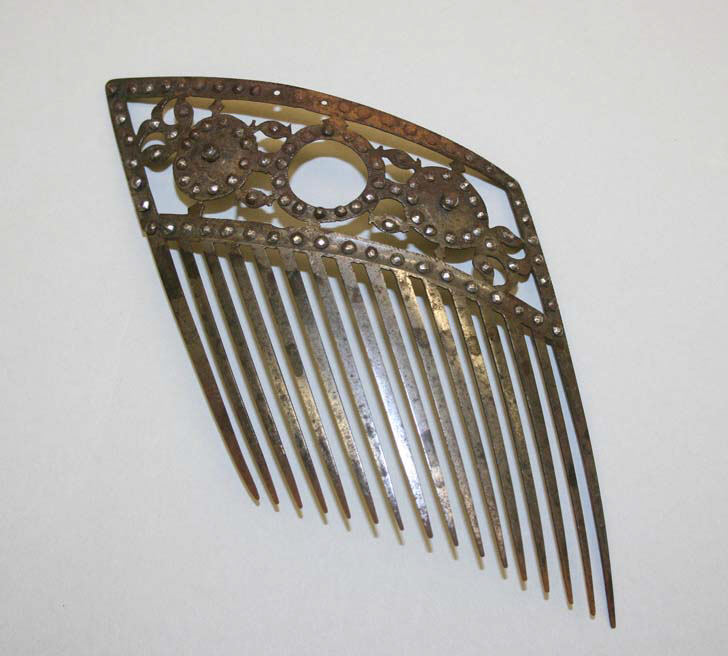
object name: comb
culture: european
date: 1799-1820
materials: steel